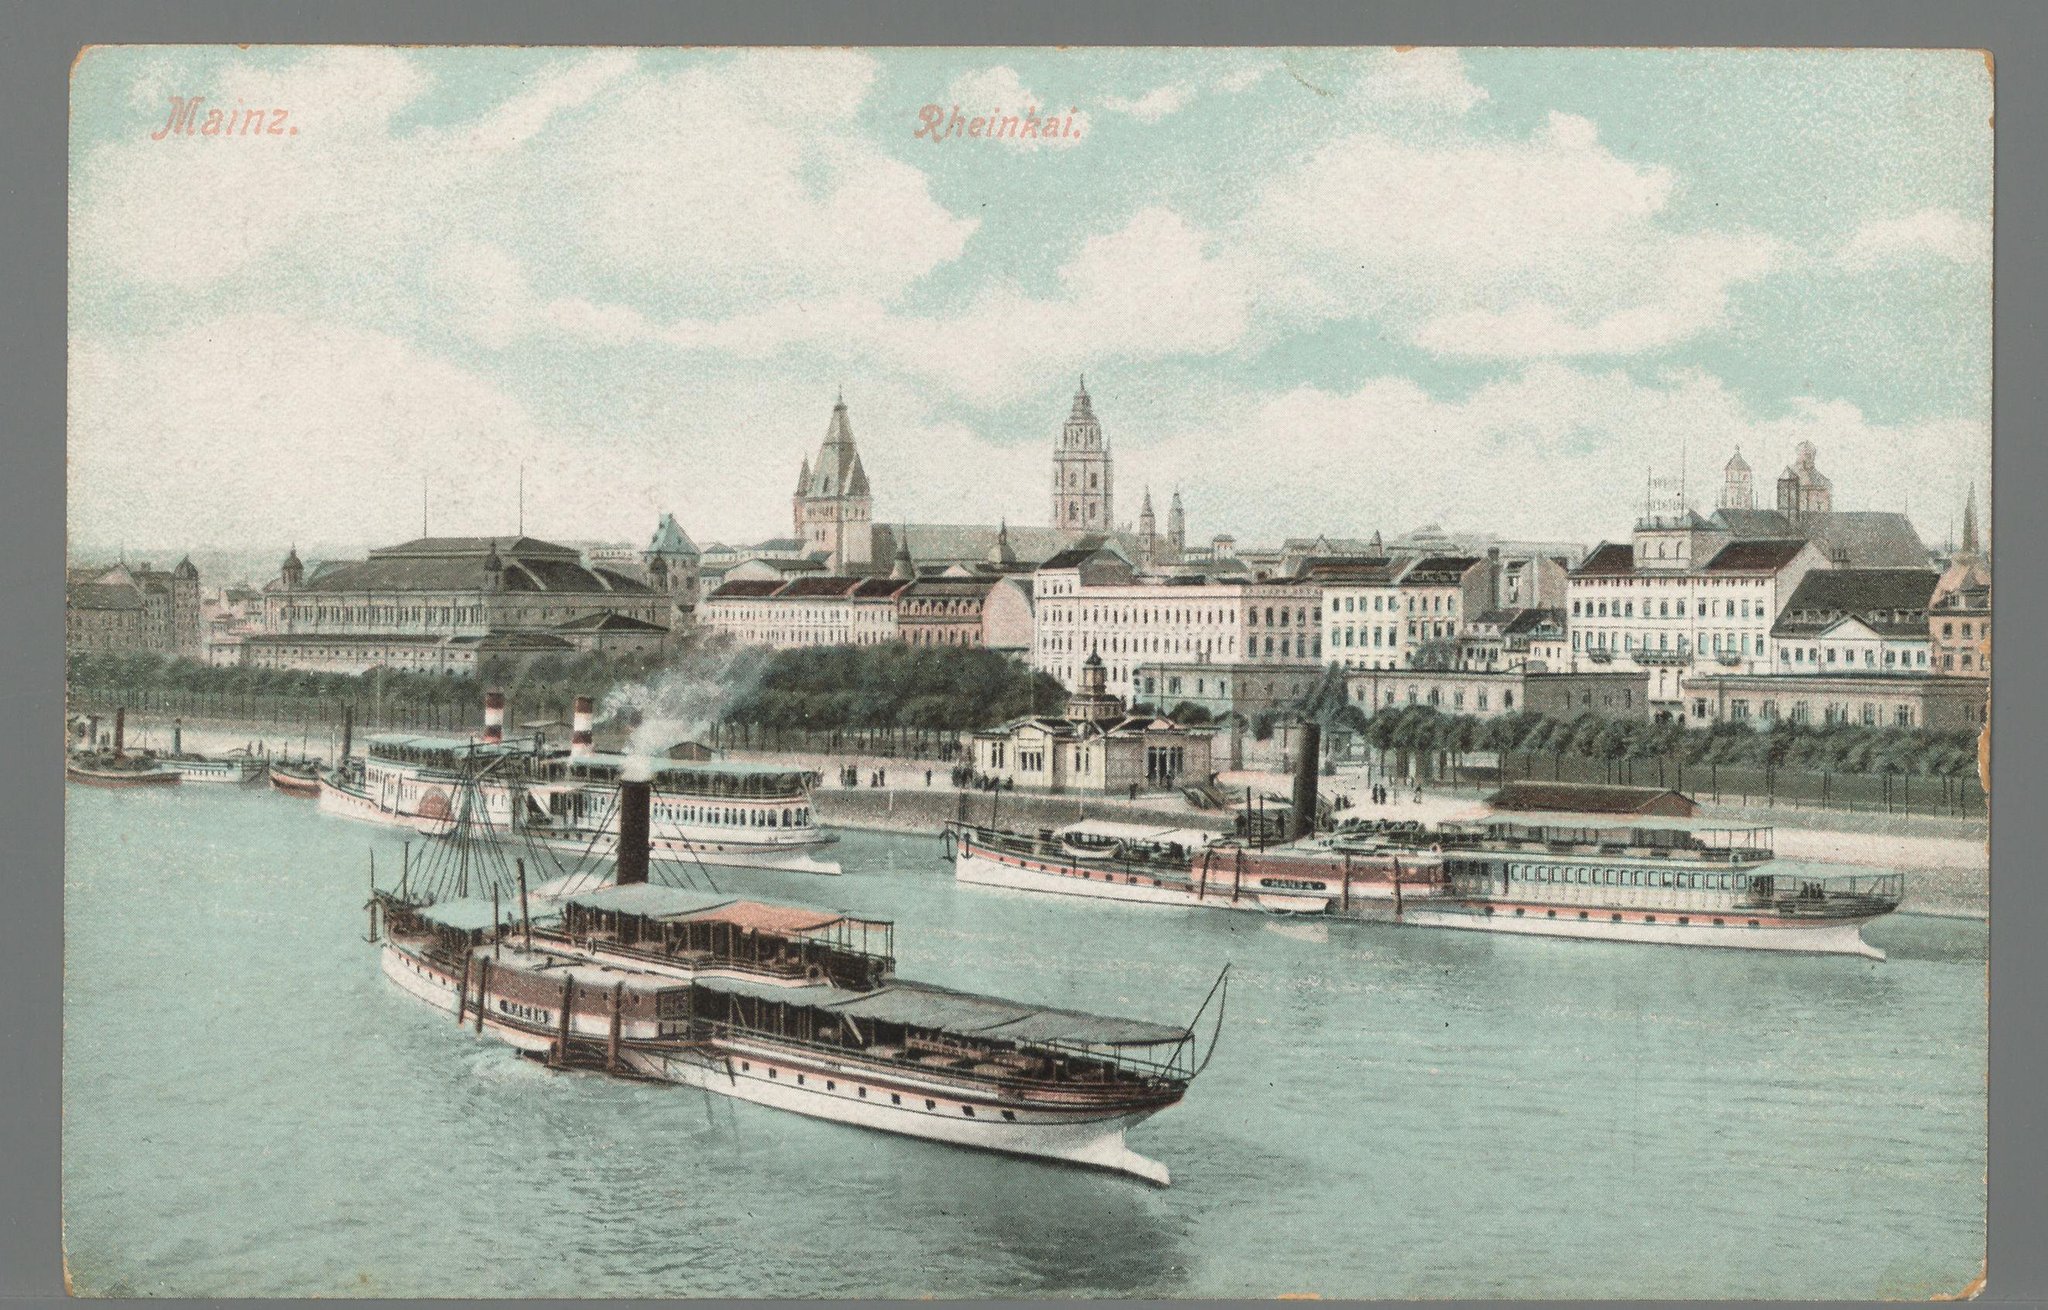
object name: photomechanical print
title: Mainz. Rheinkai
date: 1905-1908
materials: cardboard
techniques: lithograph, writing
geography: frankfurt am main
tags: city-view, and landscape with man-made constructions, canals, waters (in city)